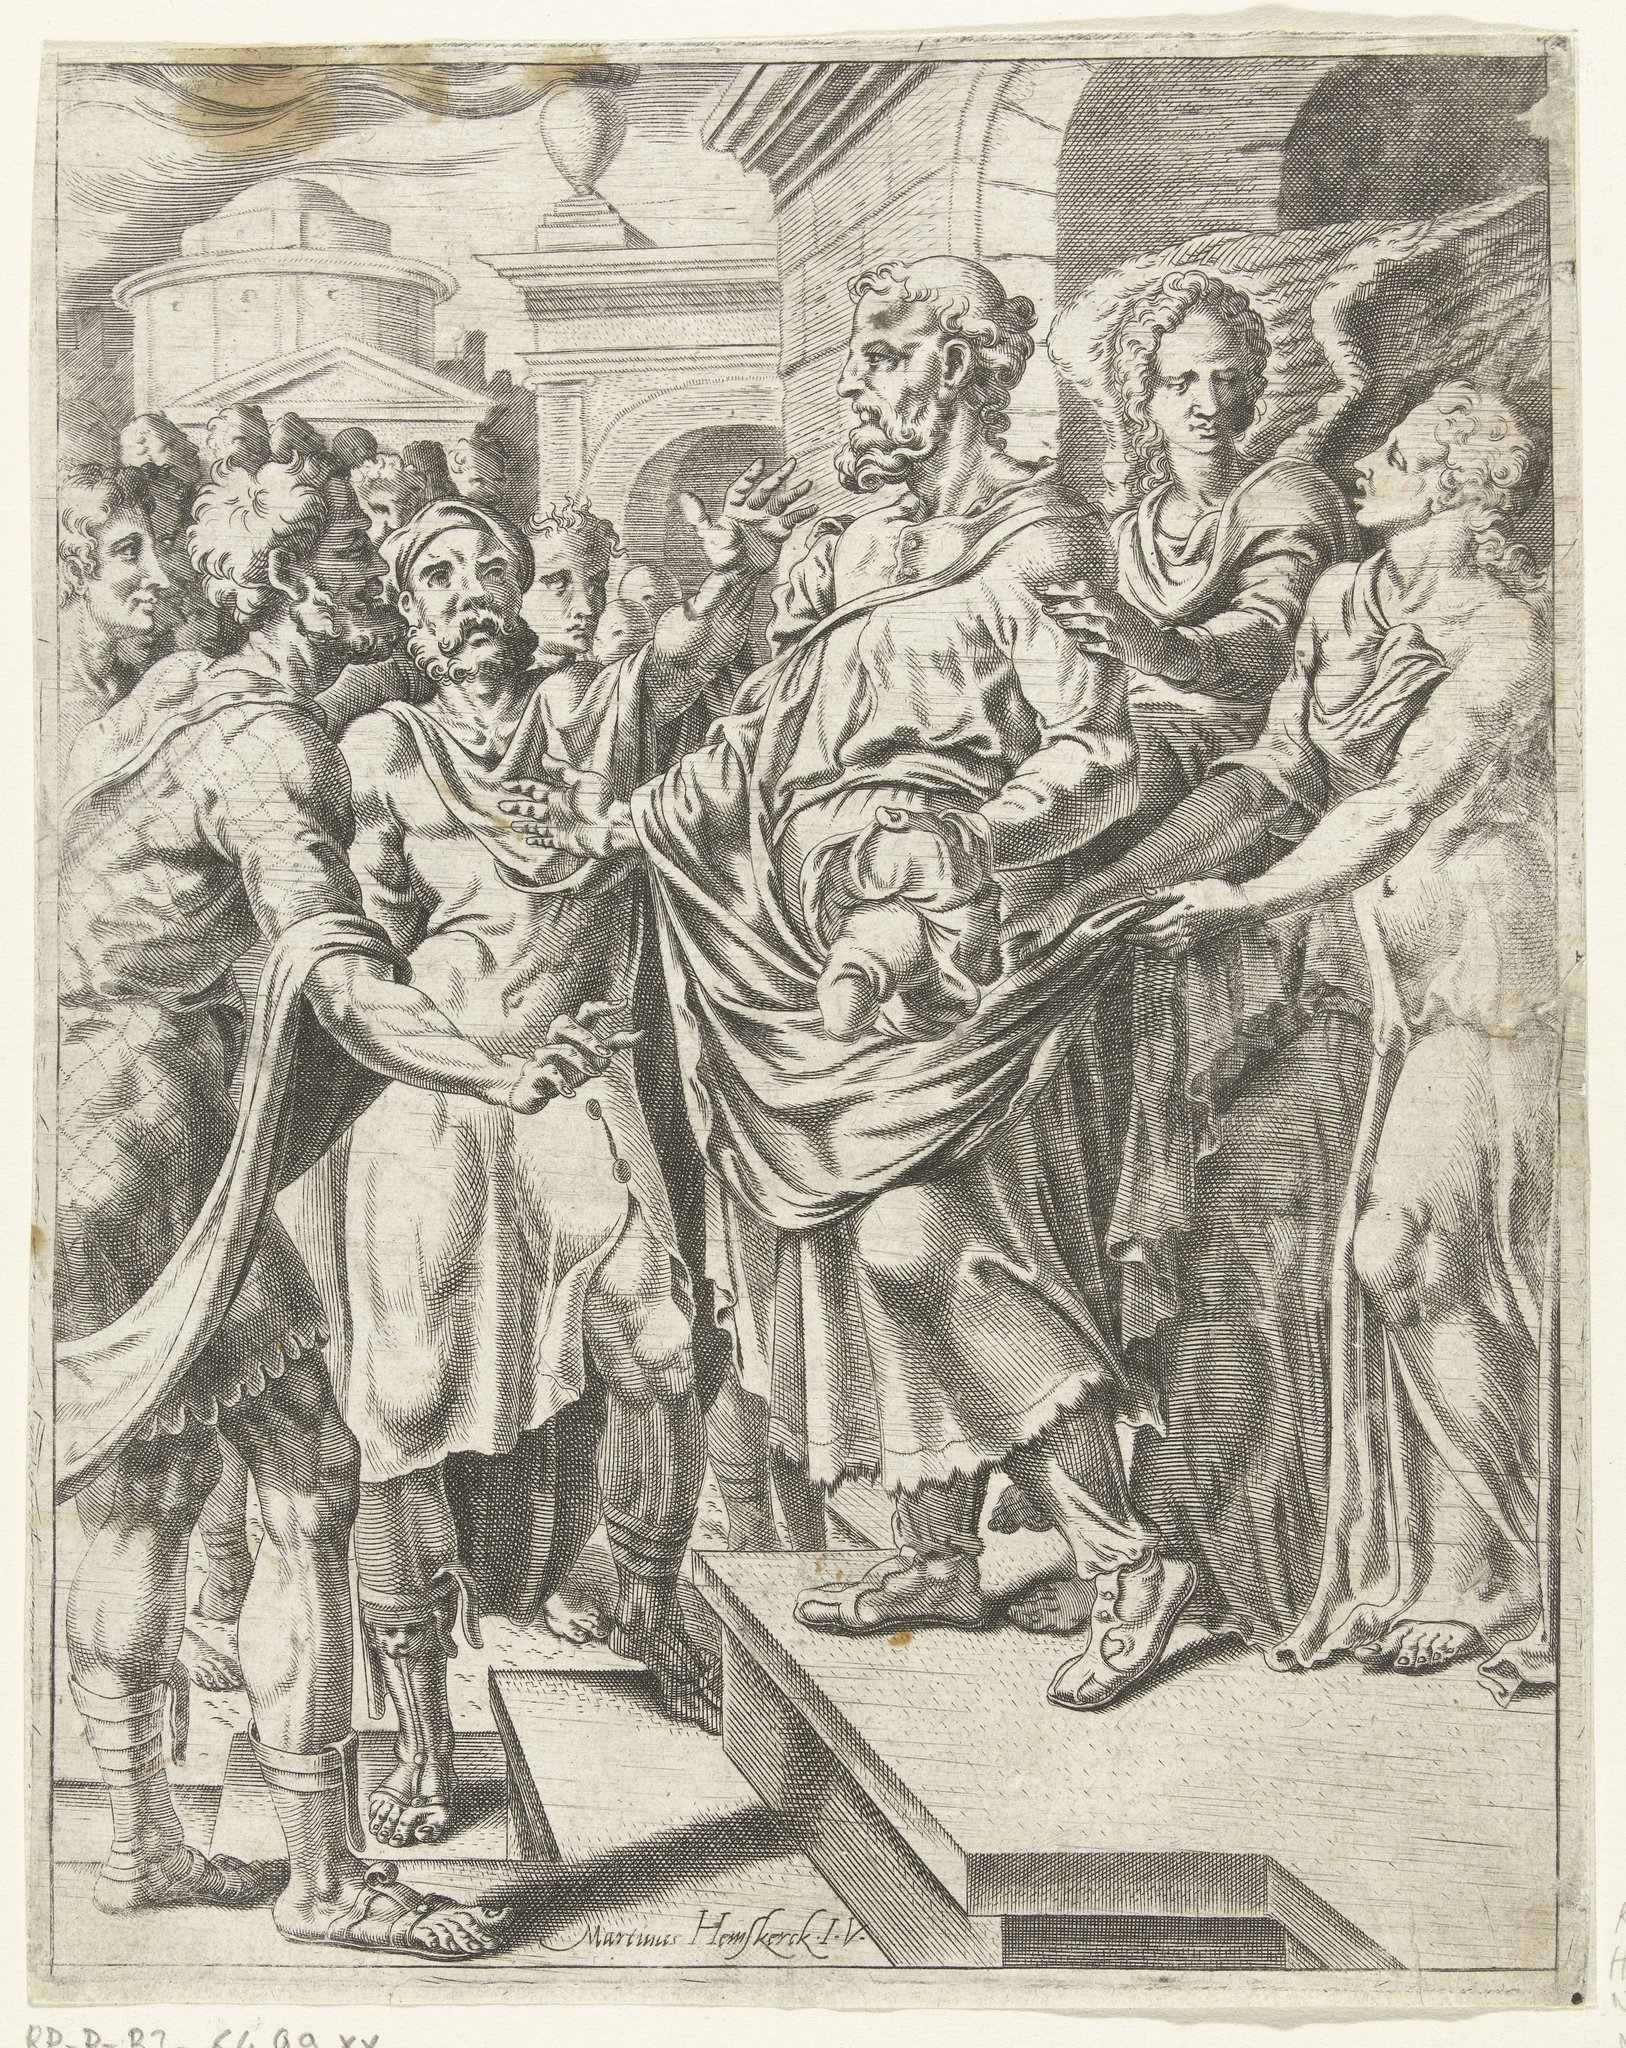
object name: print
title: De geschiedenis van Lot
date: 1551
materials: paper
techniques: engraving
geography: groningen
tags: the two angels intervene and strike the mob that surround lot's house with blindness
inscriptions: collector's mark: Lugt 2228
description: De mannen uit Sodom willen dat Lot hun de twee vreemden uitlevert, maar Lot stelt zich voor hun op. De twee engelen trekken Lot het huis in en beschermen hem zo voor de woedende menigte.